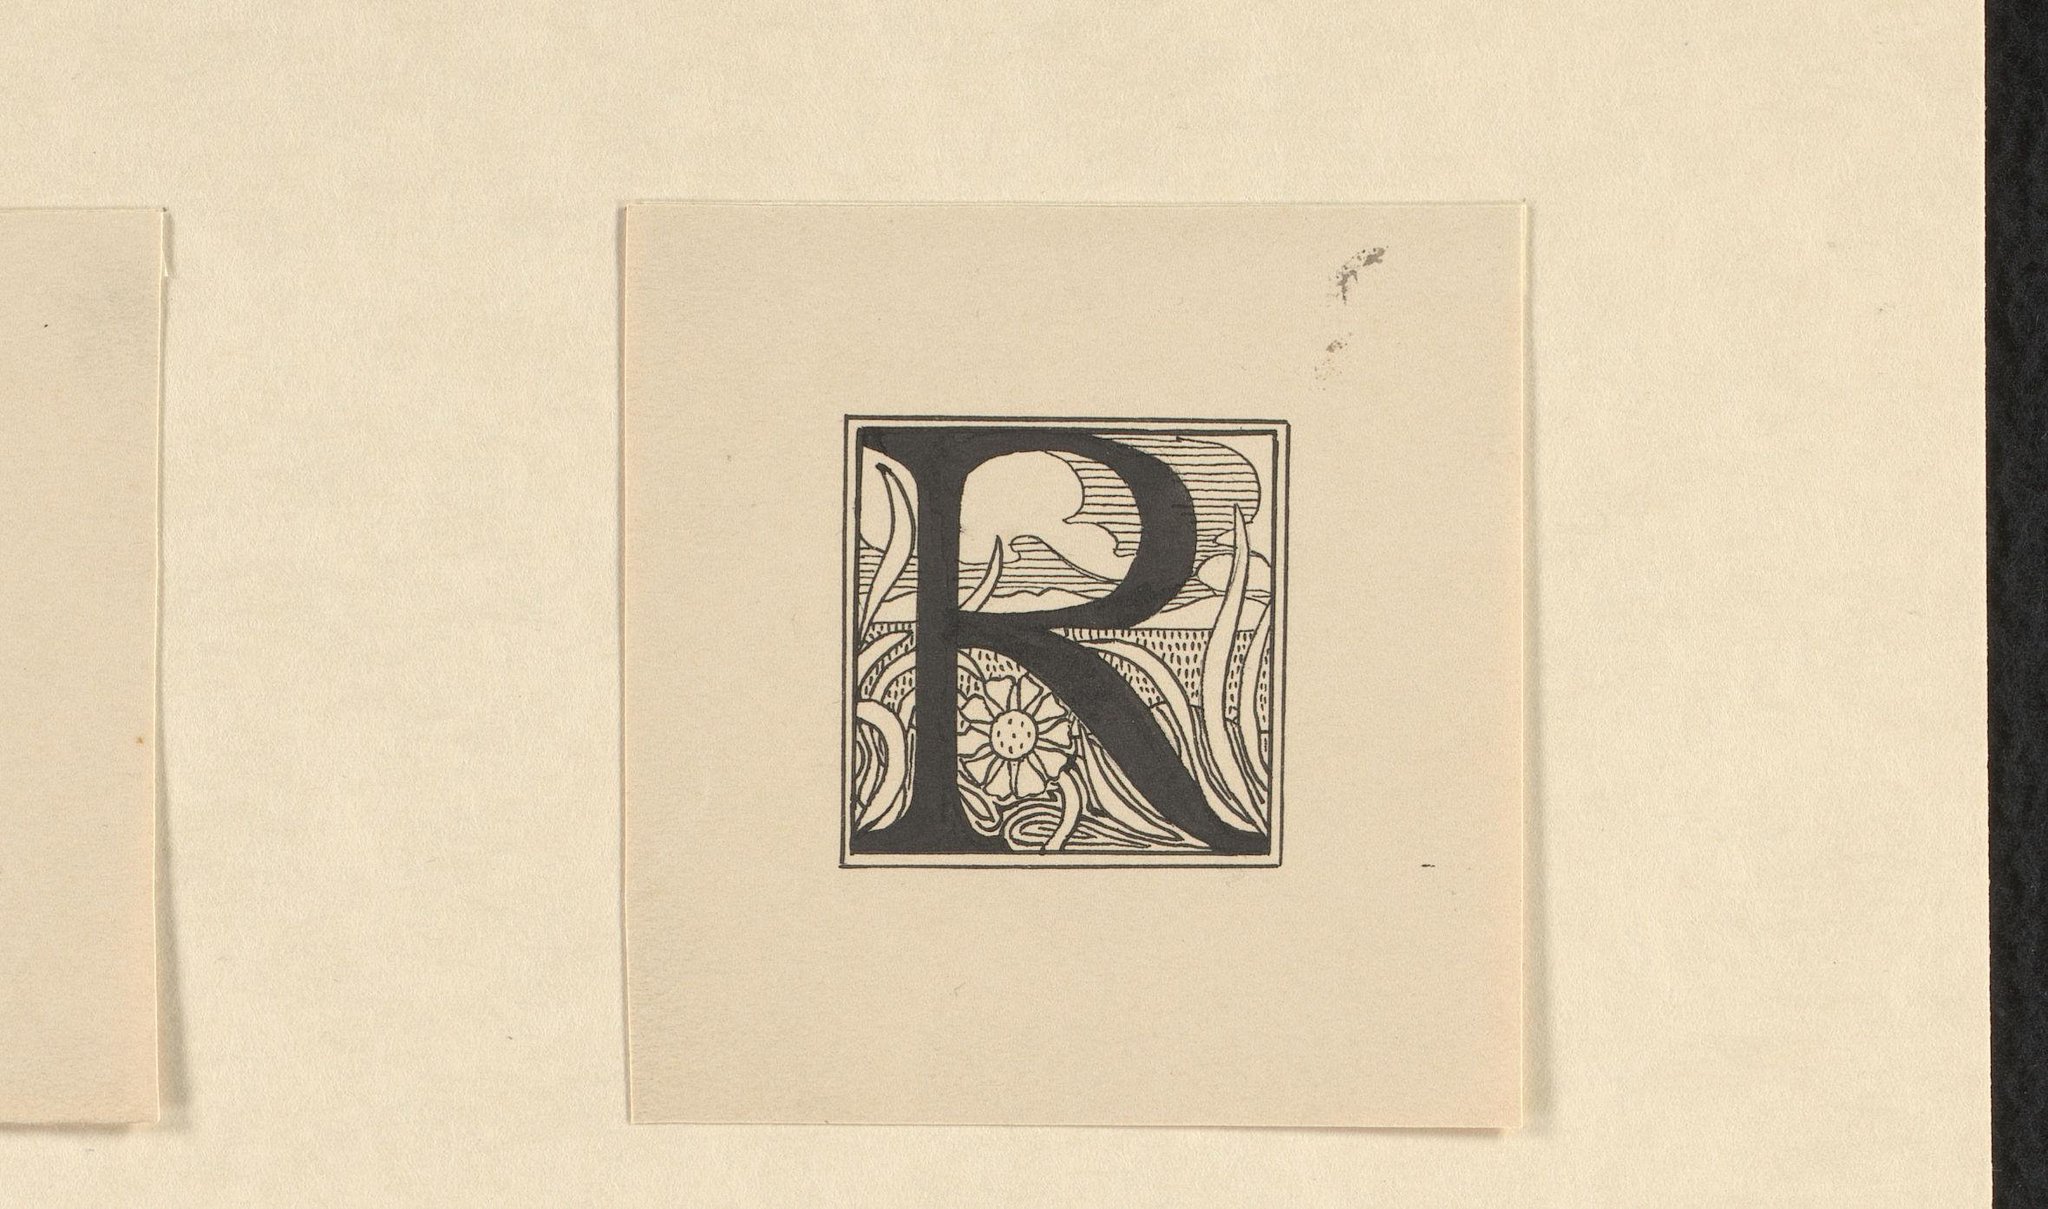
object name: boekillustratie ontwerp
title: Gedecoreerde initiaal R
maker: edzard koning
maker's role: draughtsman, print maker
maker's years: 1869-1954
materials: ink, paper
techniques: brush, pen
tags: plants; vegetation, initial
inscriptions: collector's mark: Lugt 2228, inscription: ‘hoofdst. IX’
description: Mogelijk een ontwerp voor: Eeden, Frederik van. De kleine Johannes. Den Haag: Mouton & Co., 1898. Niet gebruikt in de definitieve uitgave.